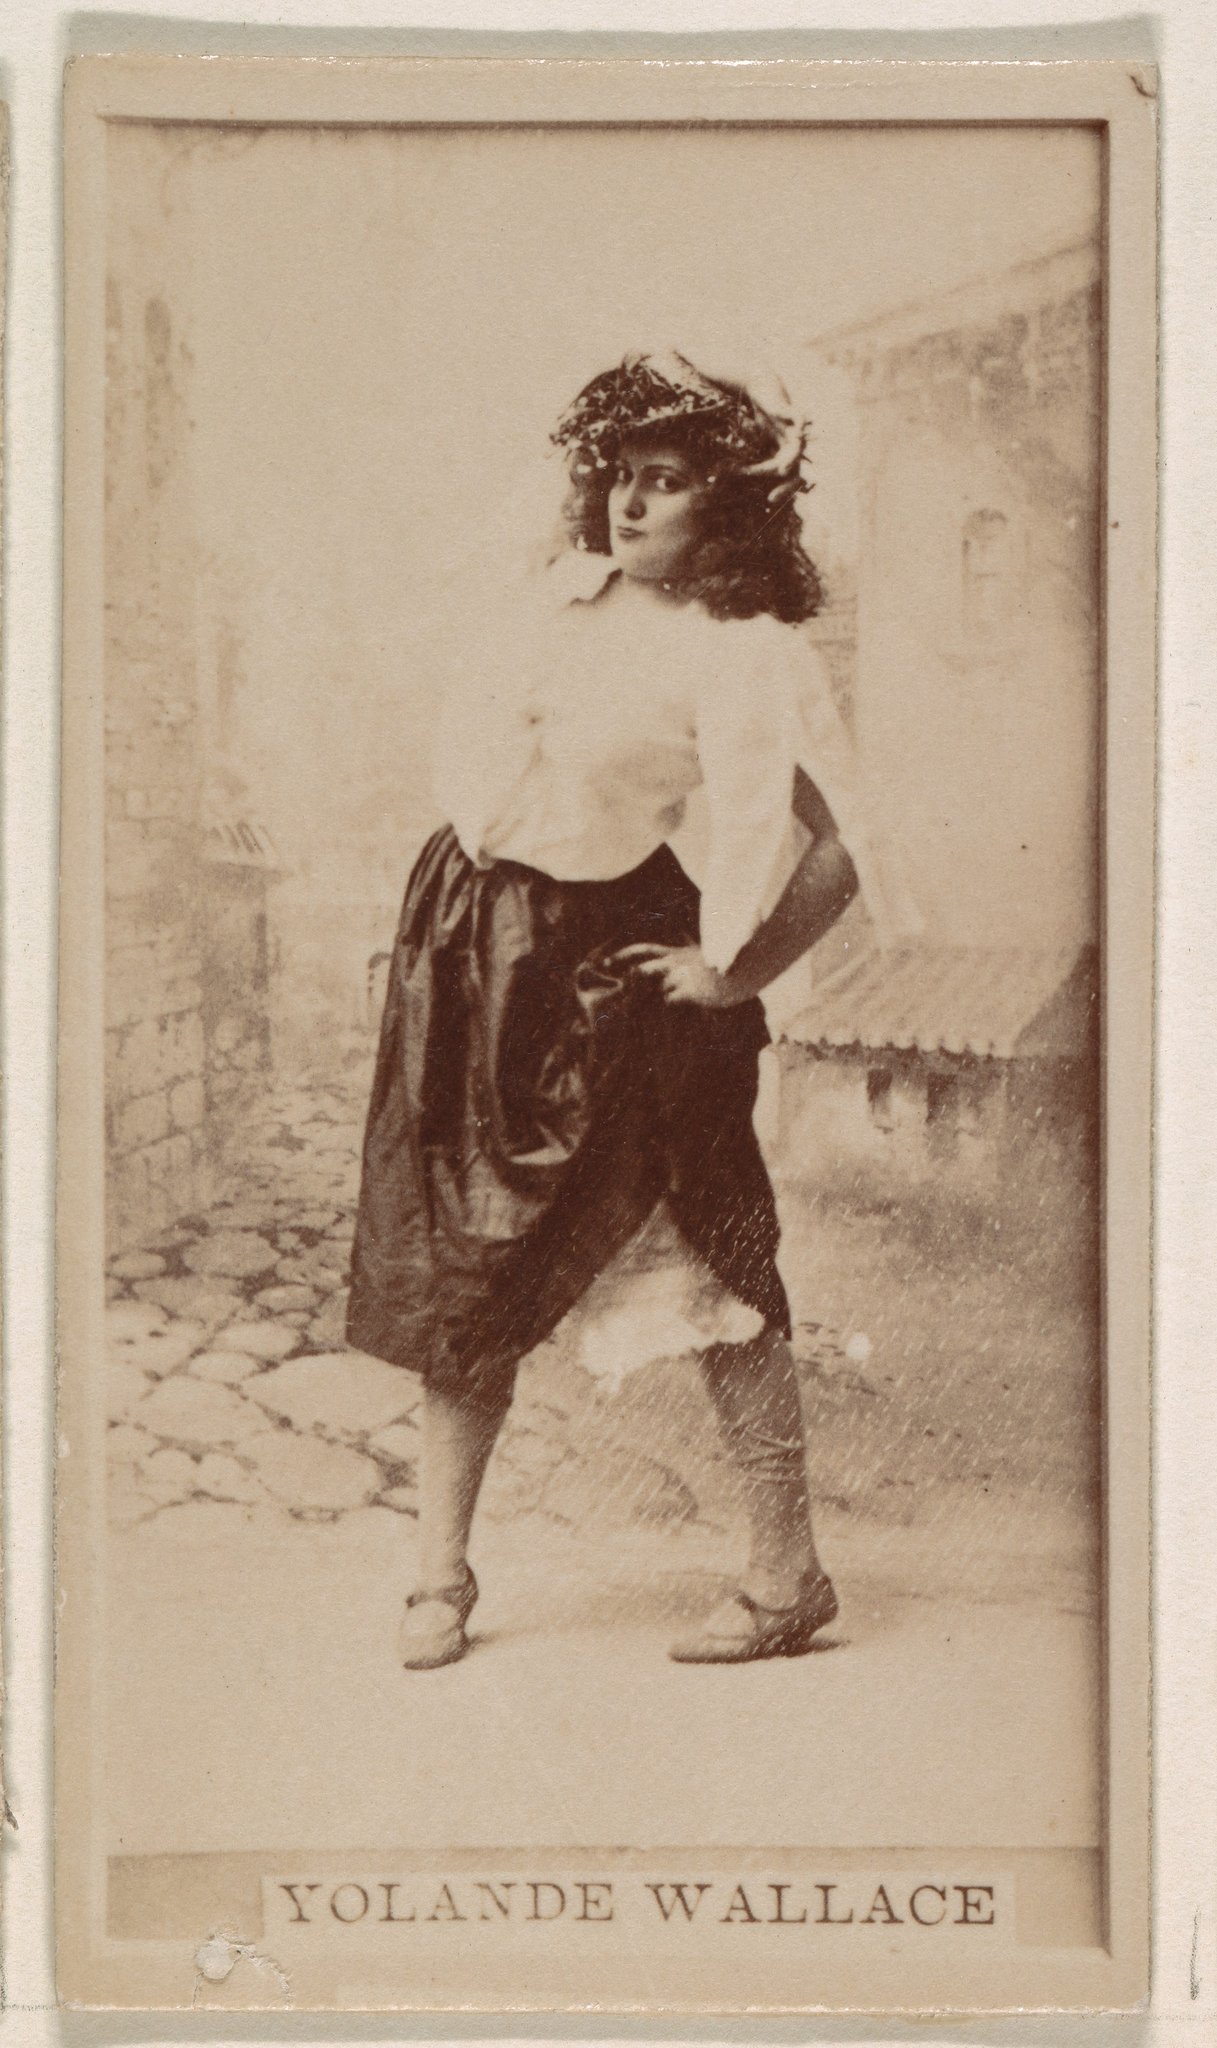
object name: photograph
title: Yolande Wallace, from the Actresses series (N245) issued by Kinney Brothers to promote Sweet Caporal Cigarettes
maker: kinney brothers tobacco company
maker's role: publisher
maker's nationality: american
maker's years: 1869-2011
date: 1890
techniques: albumen silver print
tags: profiles,women,actresses